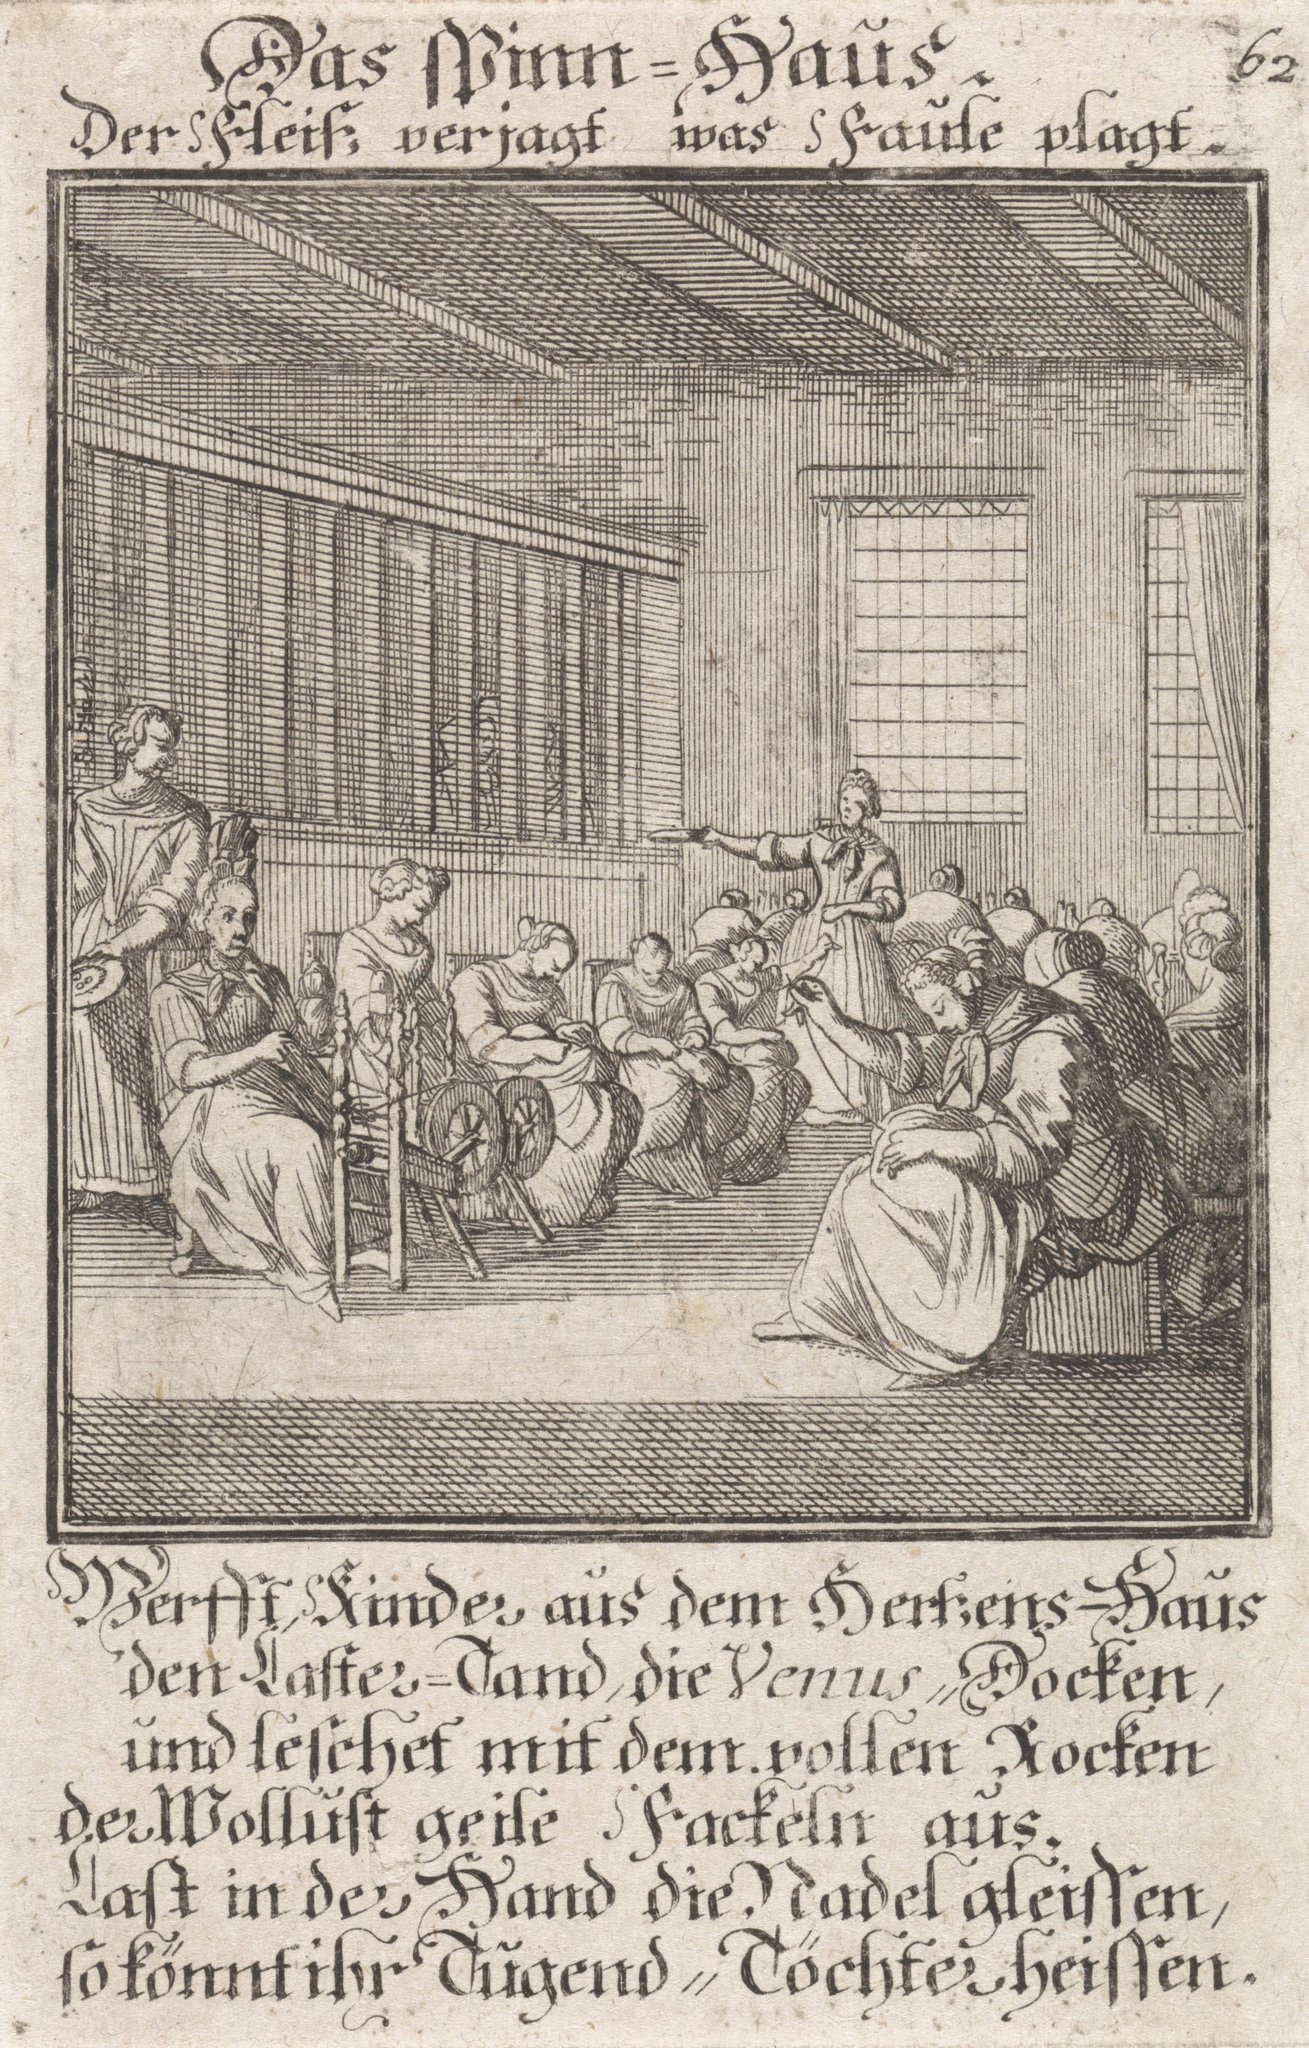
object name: print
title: Spinhuis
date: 1711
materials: paper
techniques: etching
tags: workhouse, penal camp, penitentiary, chain gang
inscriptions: collector's mark: Lugt 2228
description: Illustratie uit: Sancta Clara, Abraham à. Etwas für Alle, das ist: Eine kurtze Beschreibung allerley Stands- Ambts- und Gewerbs-Persohnen (...), 3 delen (1699-1733). Würtzburg: Martin Frank Hertz, 1711, dl. II, 621. Het betreft hier de tweede druk van deel II.